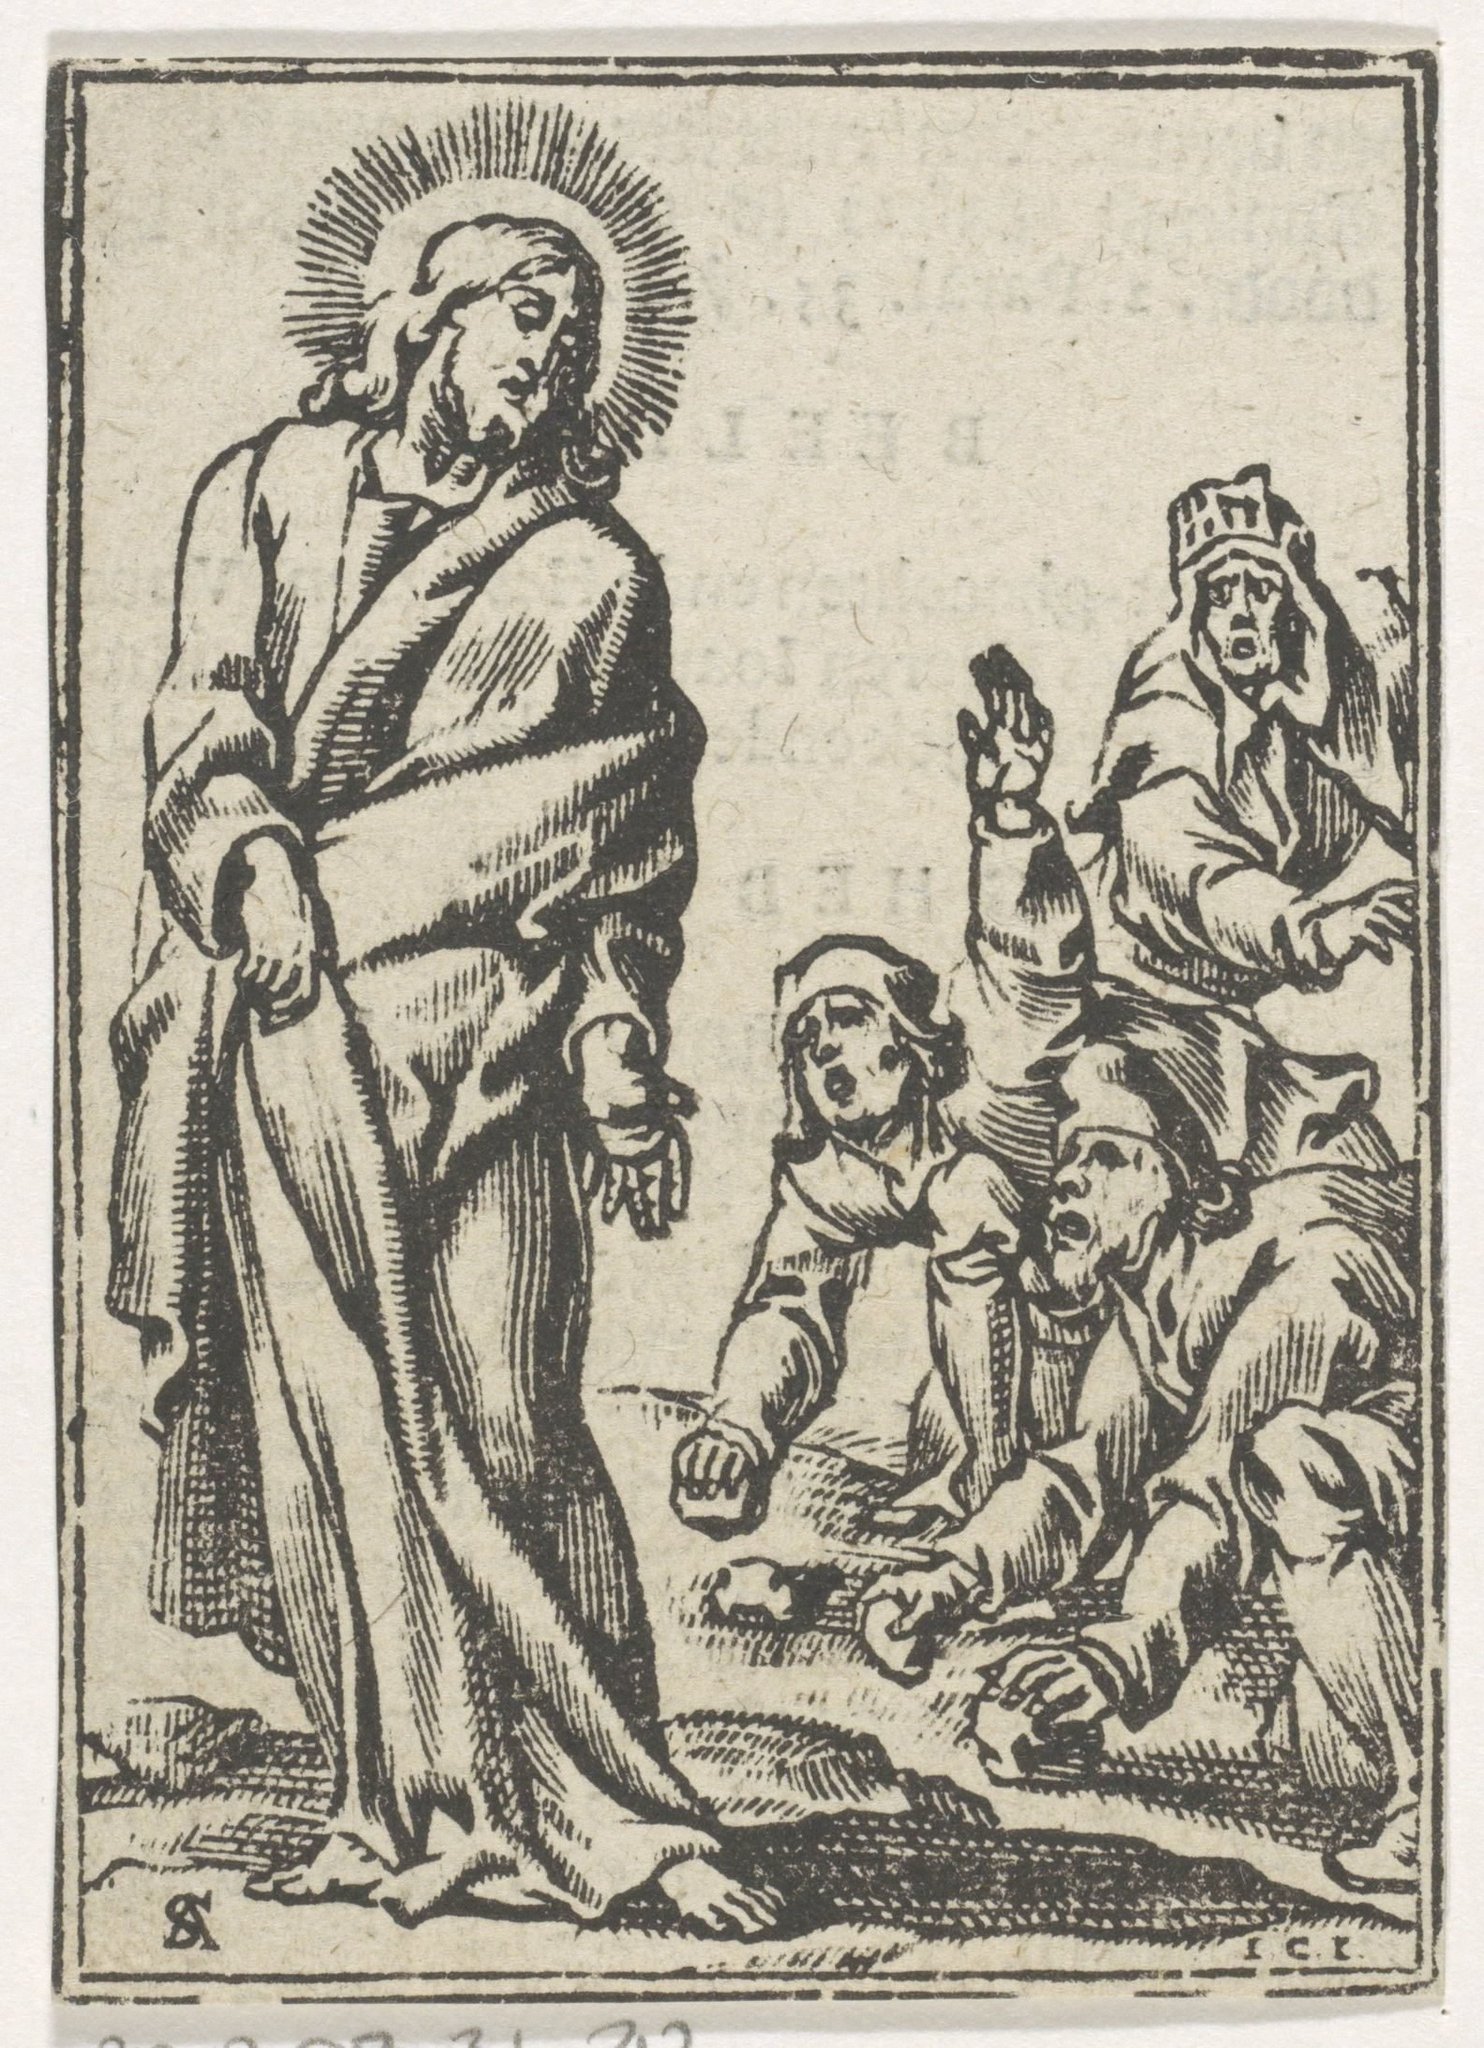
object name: book illustration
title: Joden in de tempel gooien stenen naar Christus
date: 1649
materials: paper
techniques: letterpress printing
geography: antwerp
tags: attempts to stone christ (john 8:59, 10:31-33)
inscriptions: collector's mark: Lugt 698, collector's mark: Lugt 240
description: In de tempel rapen Joodse mannen stenen op om naar Christus te gooien, nadat Christus de uitspraak heeft gedaan dat hij er al voor Abraham was.